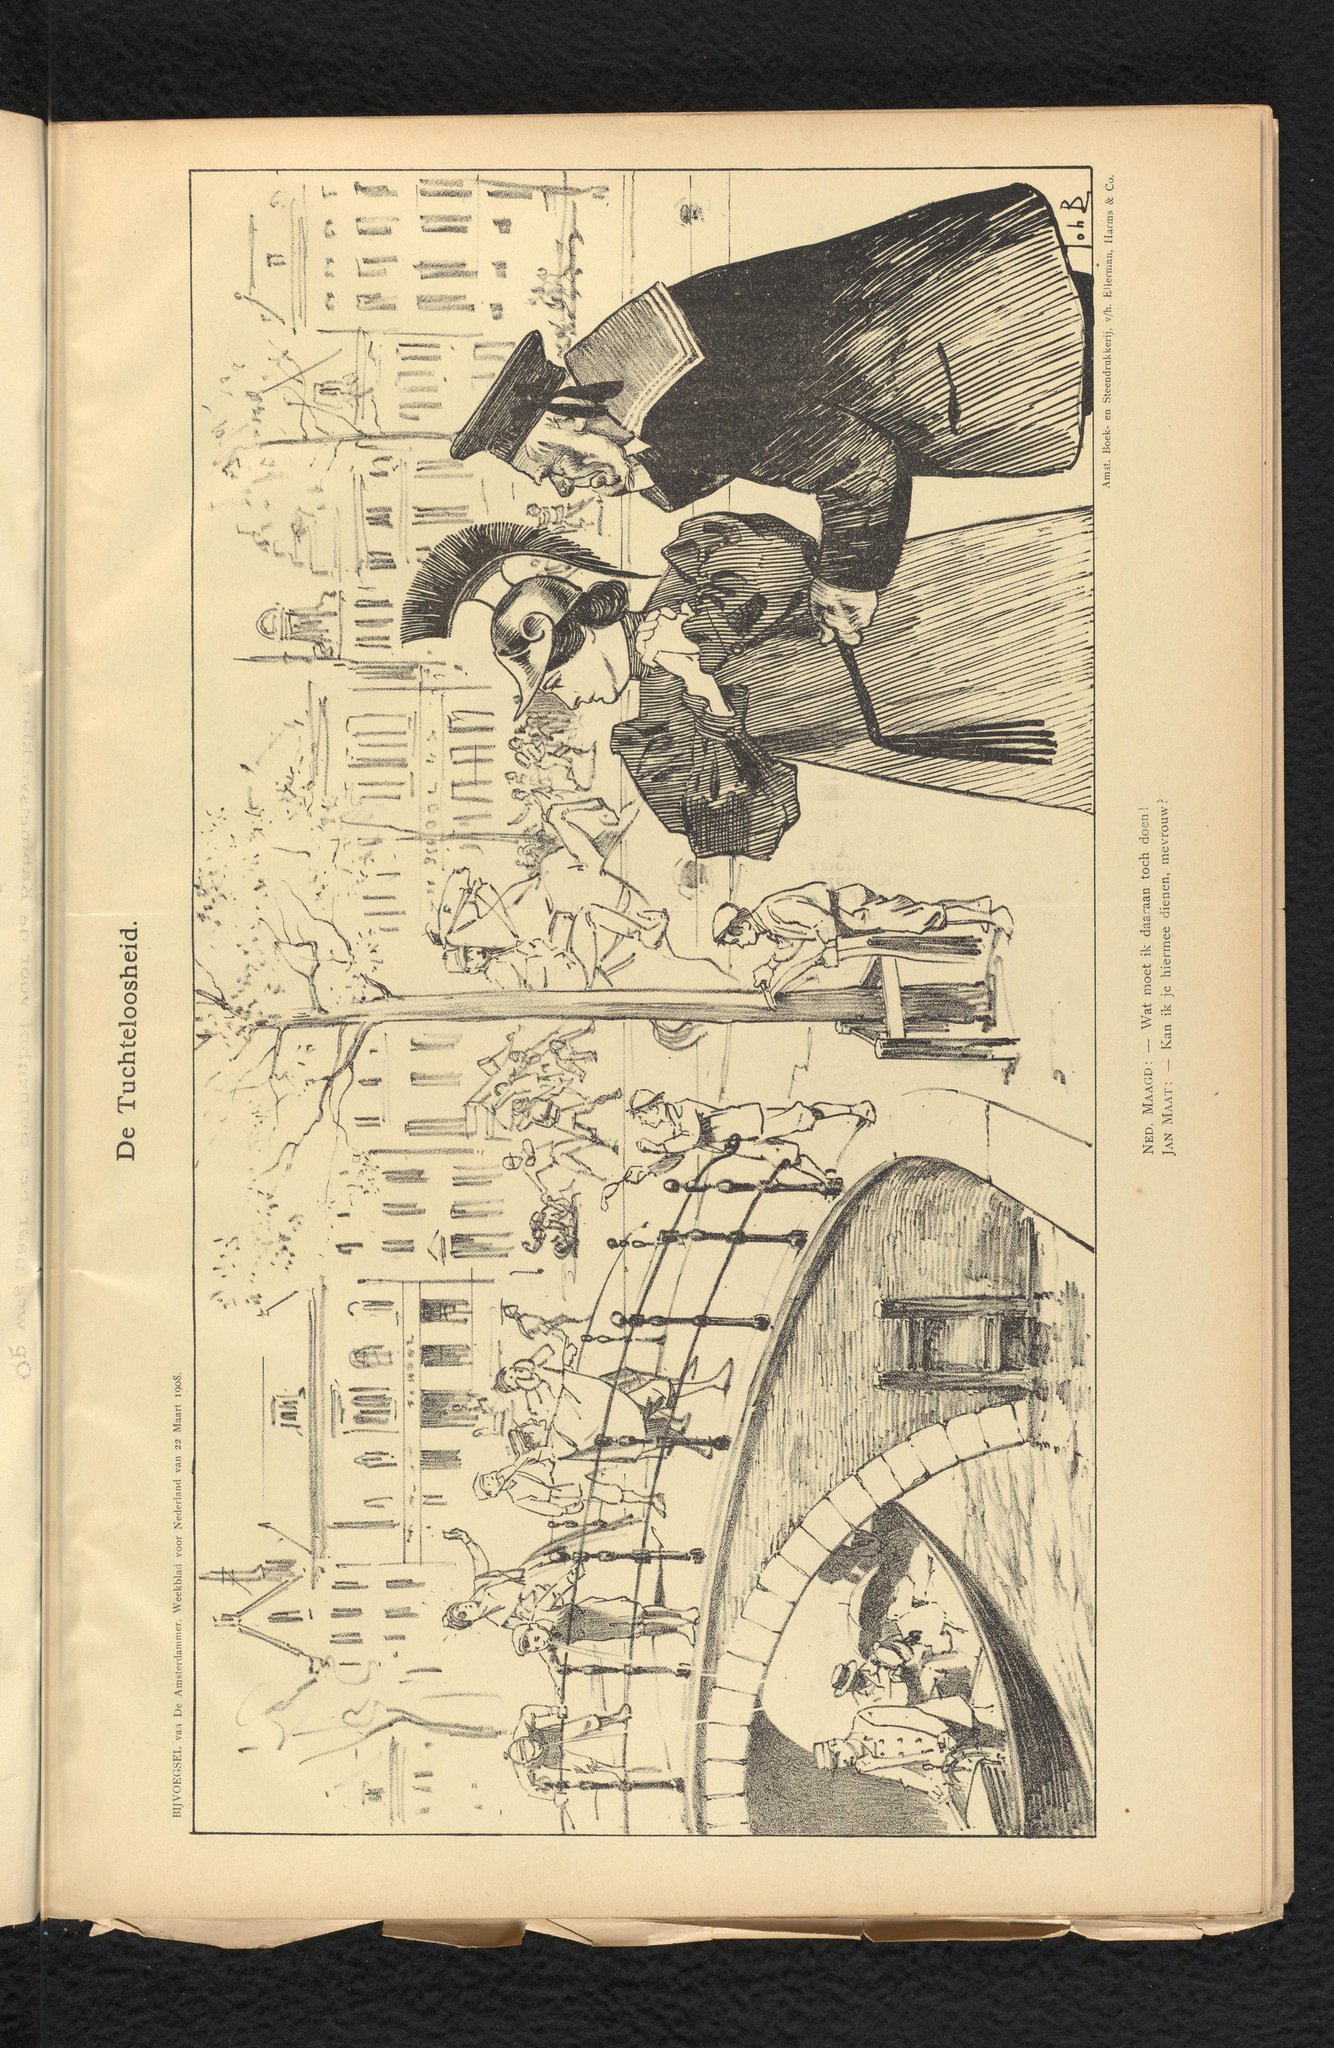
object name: cartoon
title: De Tuchteloosheid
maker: johan braakensiek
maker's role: draughtsman, print maker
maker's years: 1858-1940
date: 1908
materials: paper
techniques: lithograph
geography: netherlands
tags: spitting, personifications of countries, nations, states, districts, etc., vandalism (mischief-making play), political caricatures and satires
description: De Nederlandse Maagd en Jan Maat, een oude matroos, maken zich zorgen over het toenemende vandalisme en kattenkwaad van jongens op straat. Twee jongens spugen bijvoorbeeld vanaf een brug op een daaronder passerende open boot met passagiers.